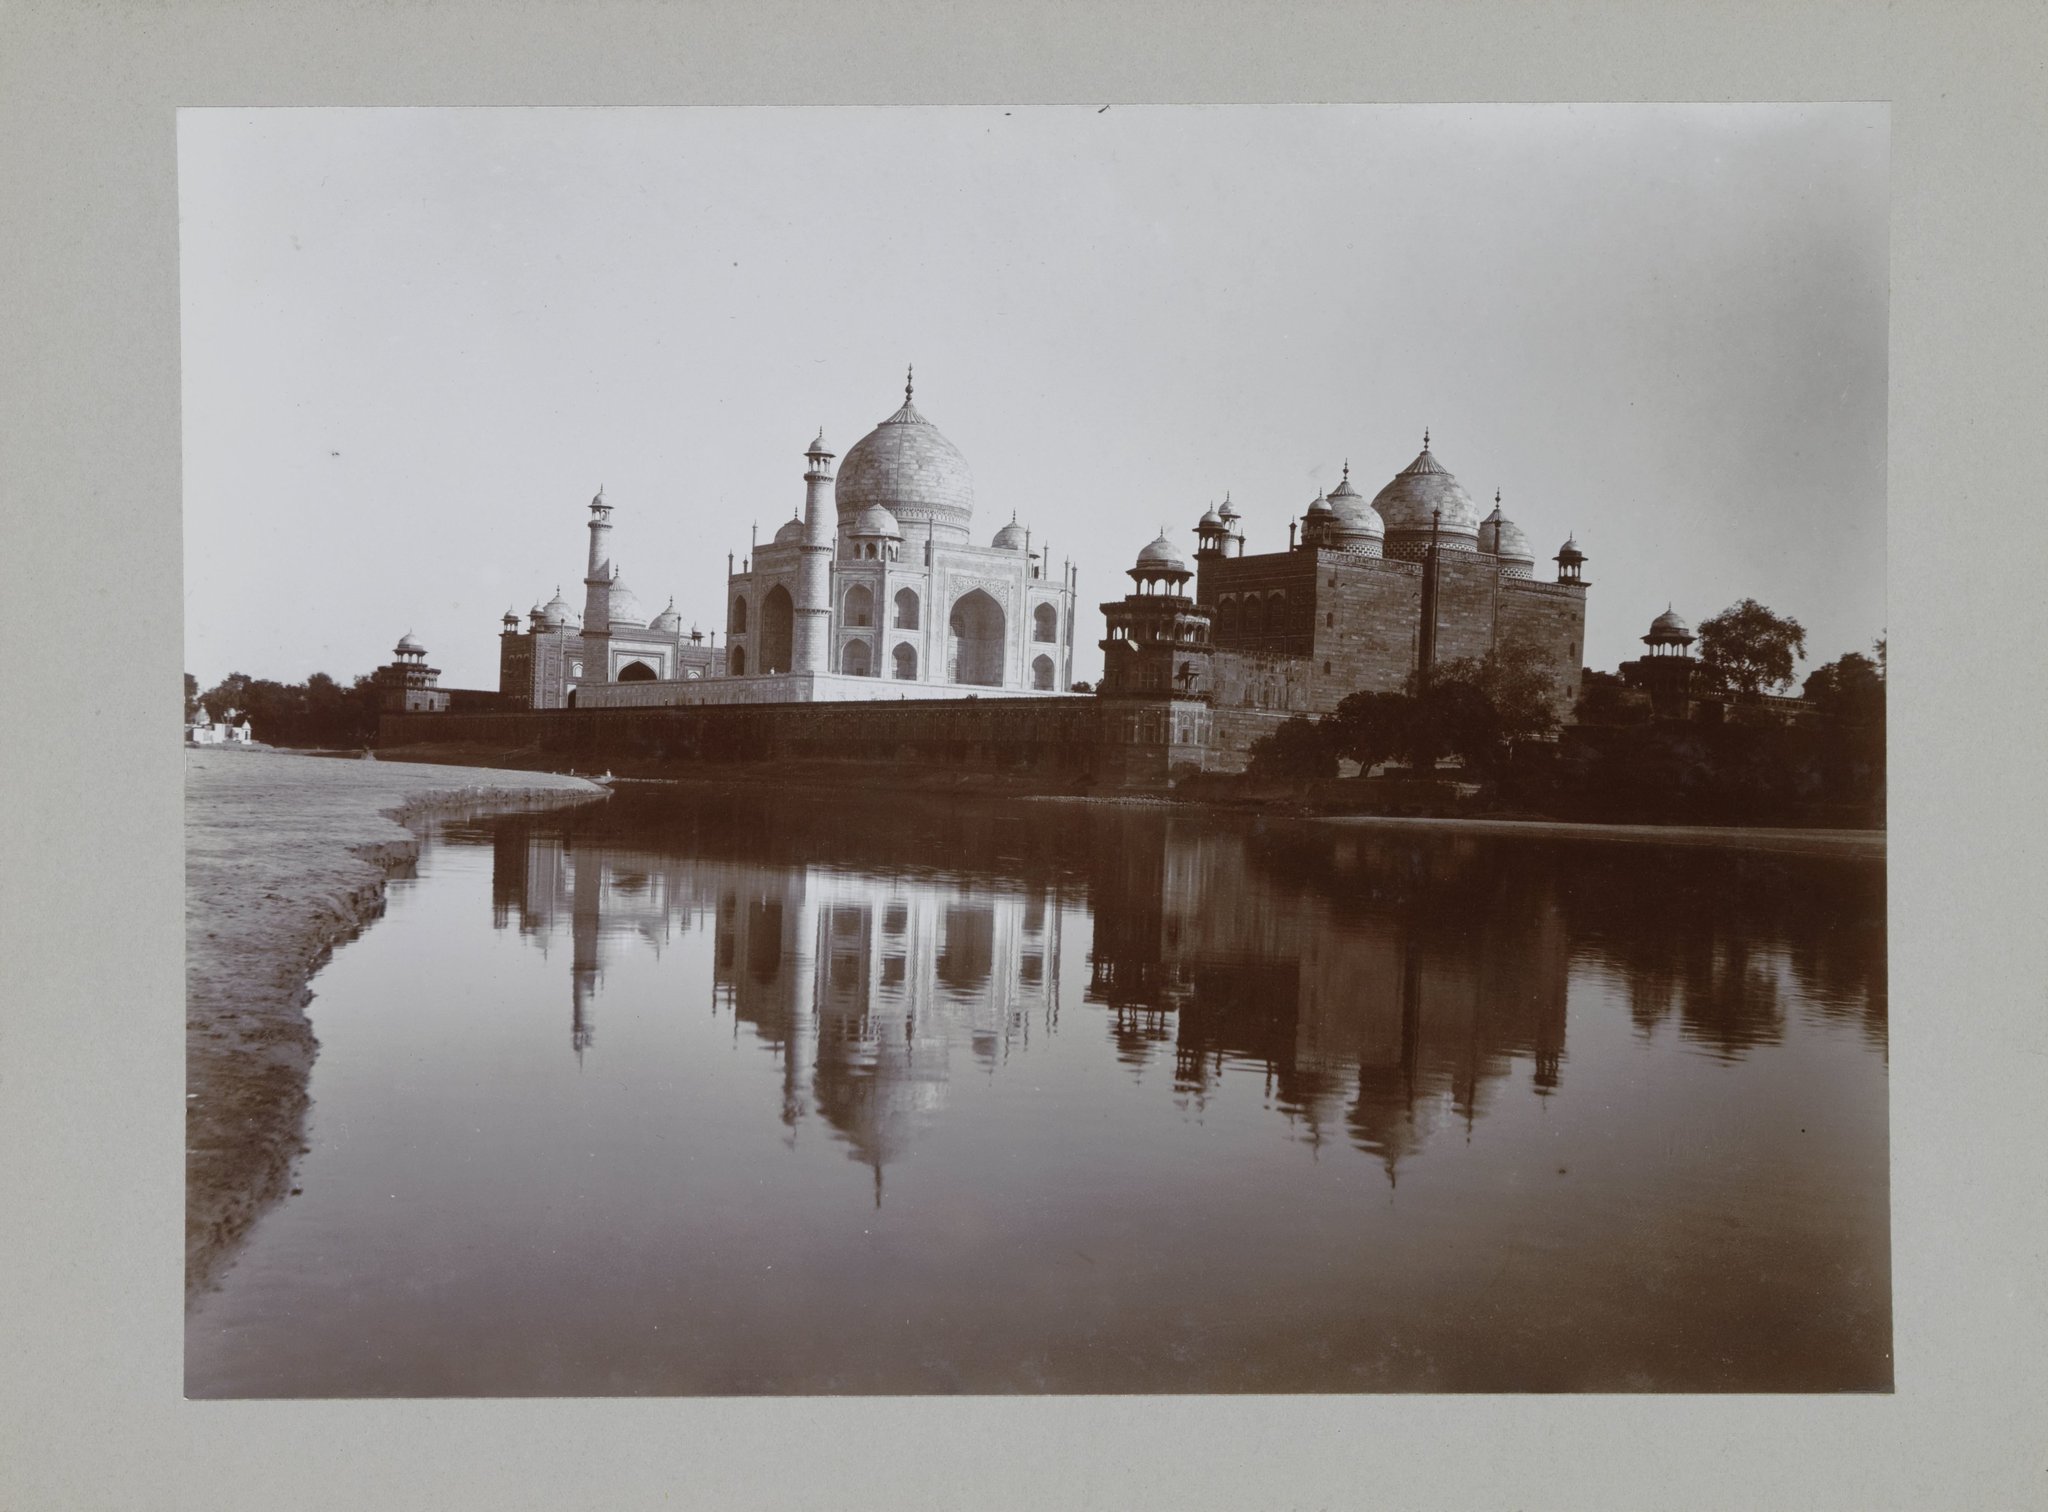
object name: photograph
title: View of the Taj Mahal from the Yamuna river, Agra, Uttar Pradesh, India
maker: Anonymous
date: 1895-1915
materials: cardboard, paper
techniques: gelatin silver print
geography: agra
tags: agra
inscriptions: annotation: ‘55. Taj. Mahal’